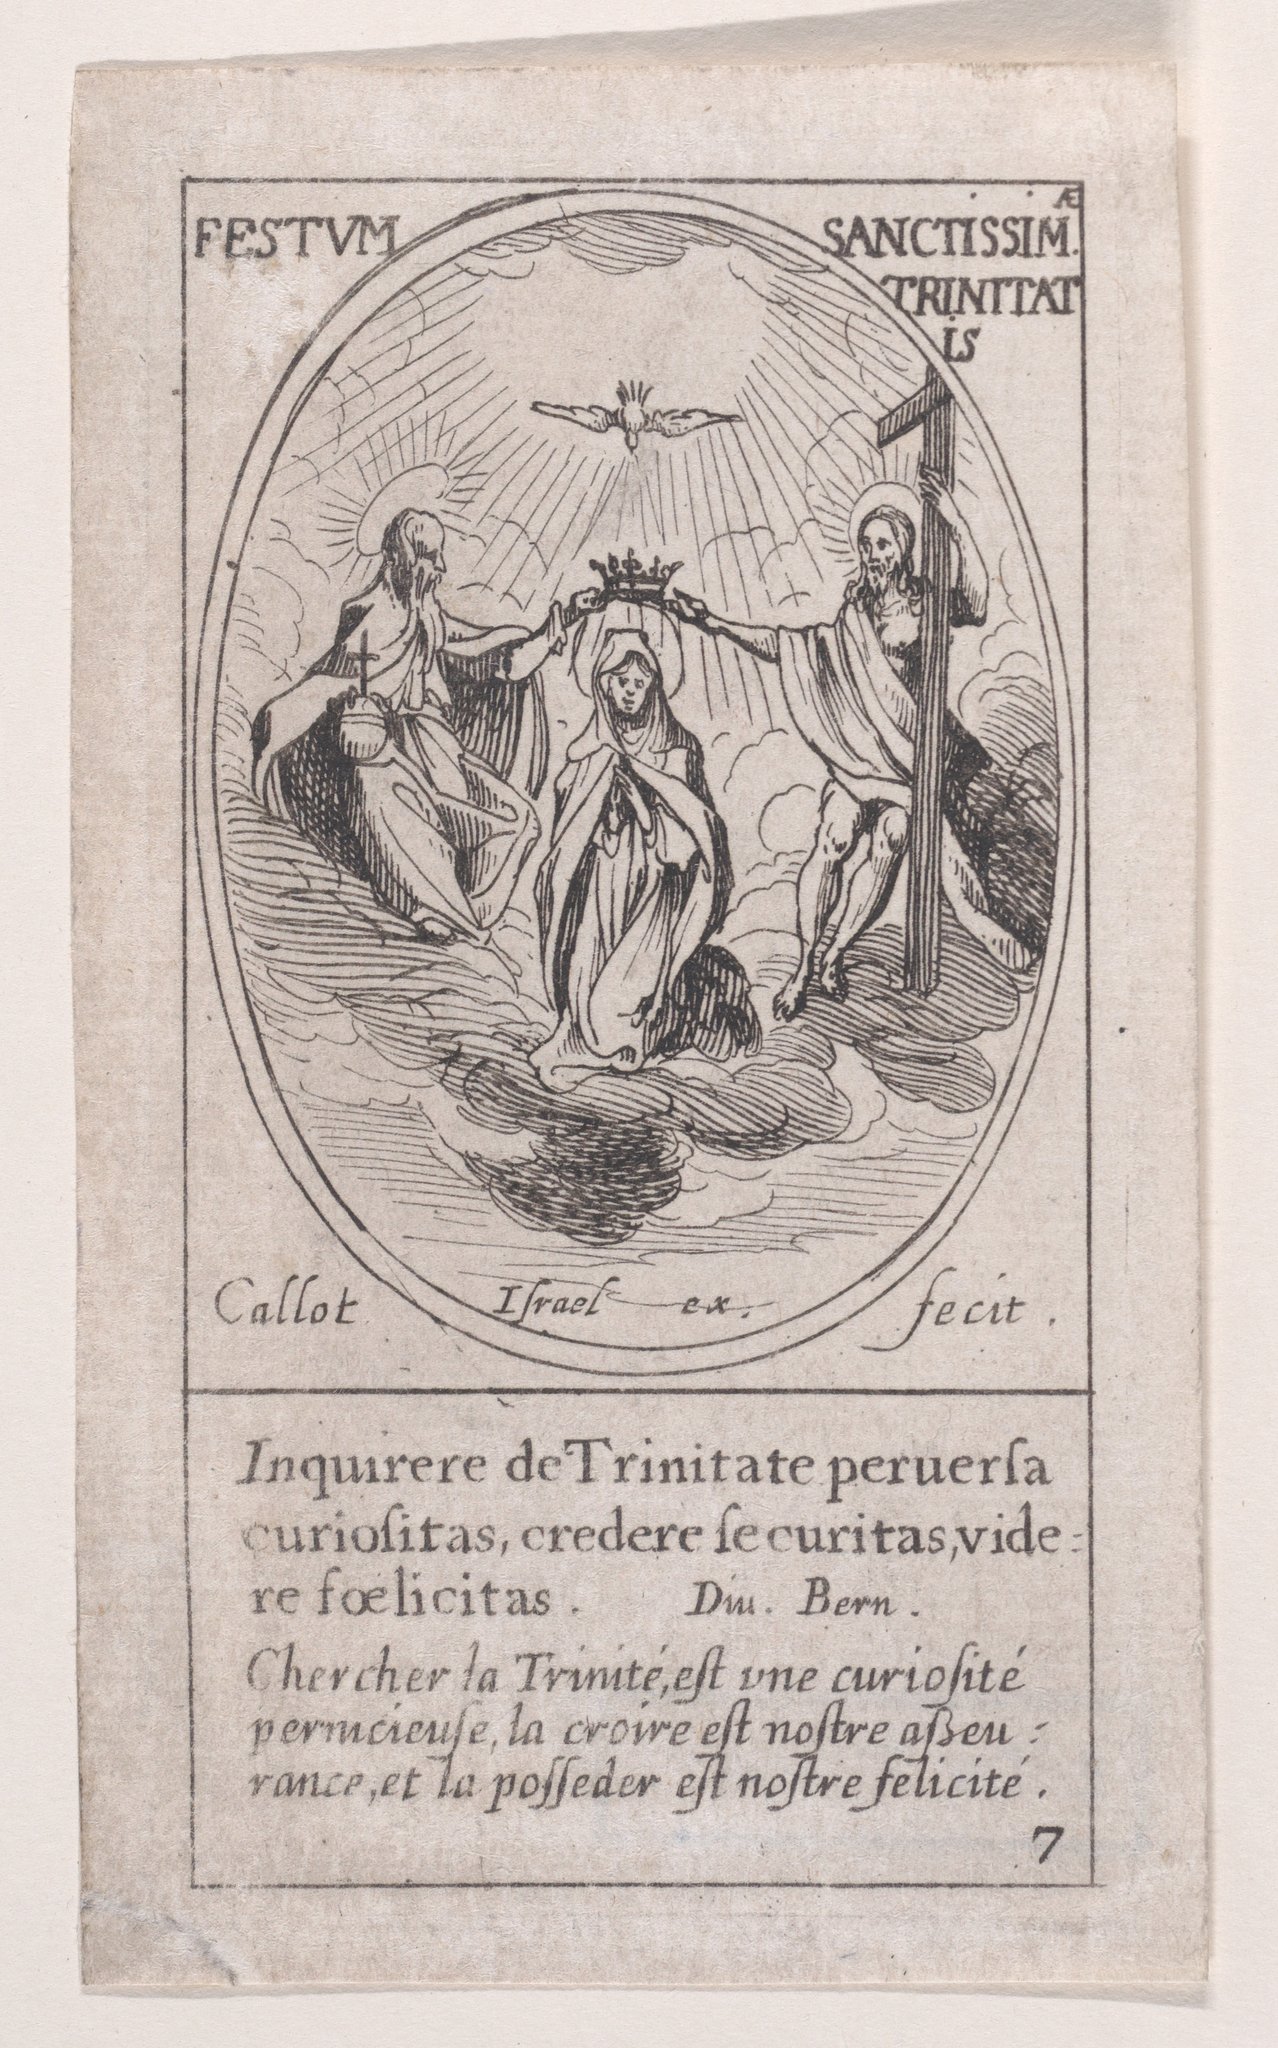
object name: print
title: La Trinité (The Trinity), Trinity Sunday, scene 7 from Images des Fêtes Mobiles (Images of Moveable Feasts from the Christian Calendar), part of "Les Images De Tous Les Saincts et Saintes de L'Année" (Images of All of the Saints and Religious Events of the Year)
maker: jacques callot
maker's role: artist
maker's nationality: french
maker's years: 1592-1635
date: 1632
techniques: etching